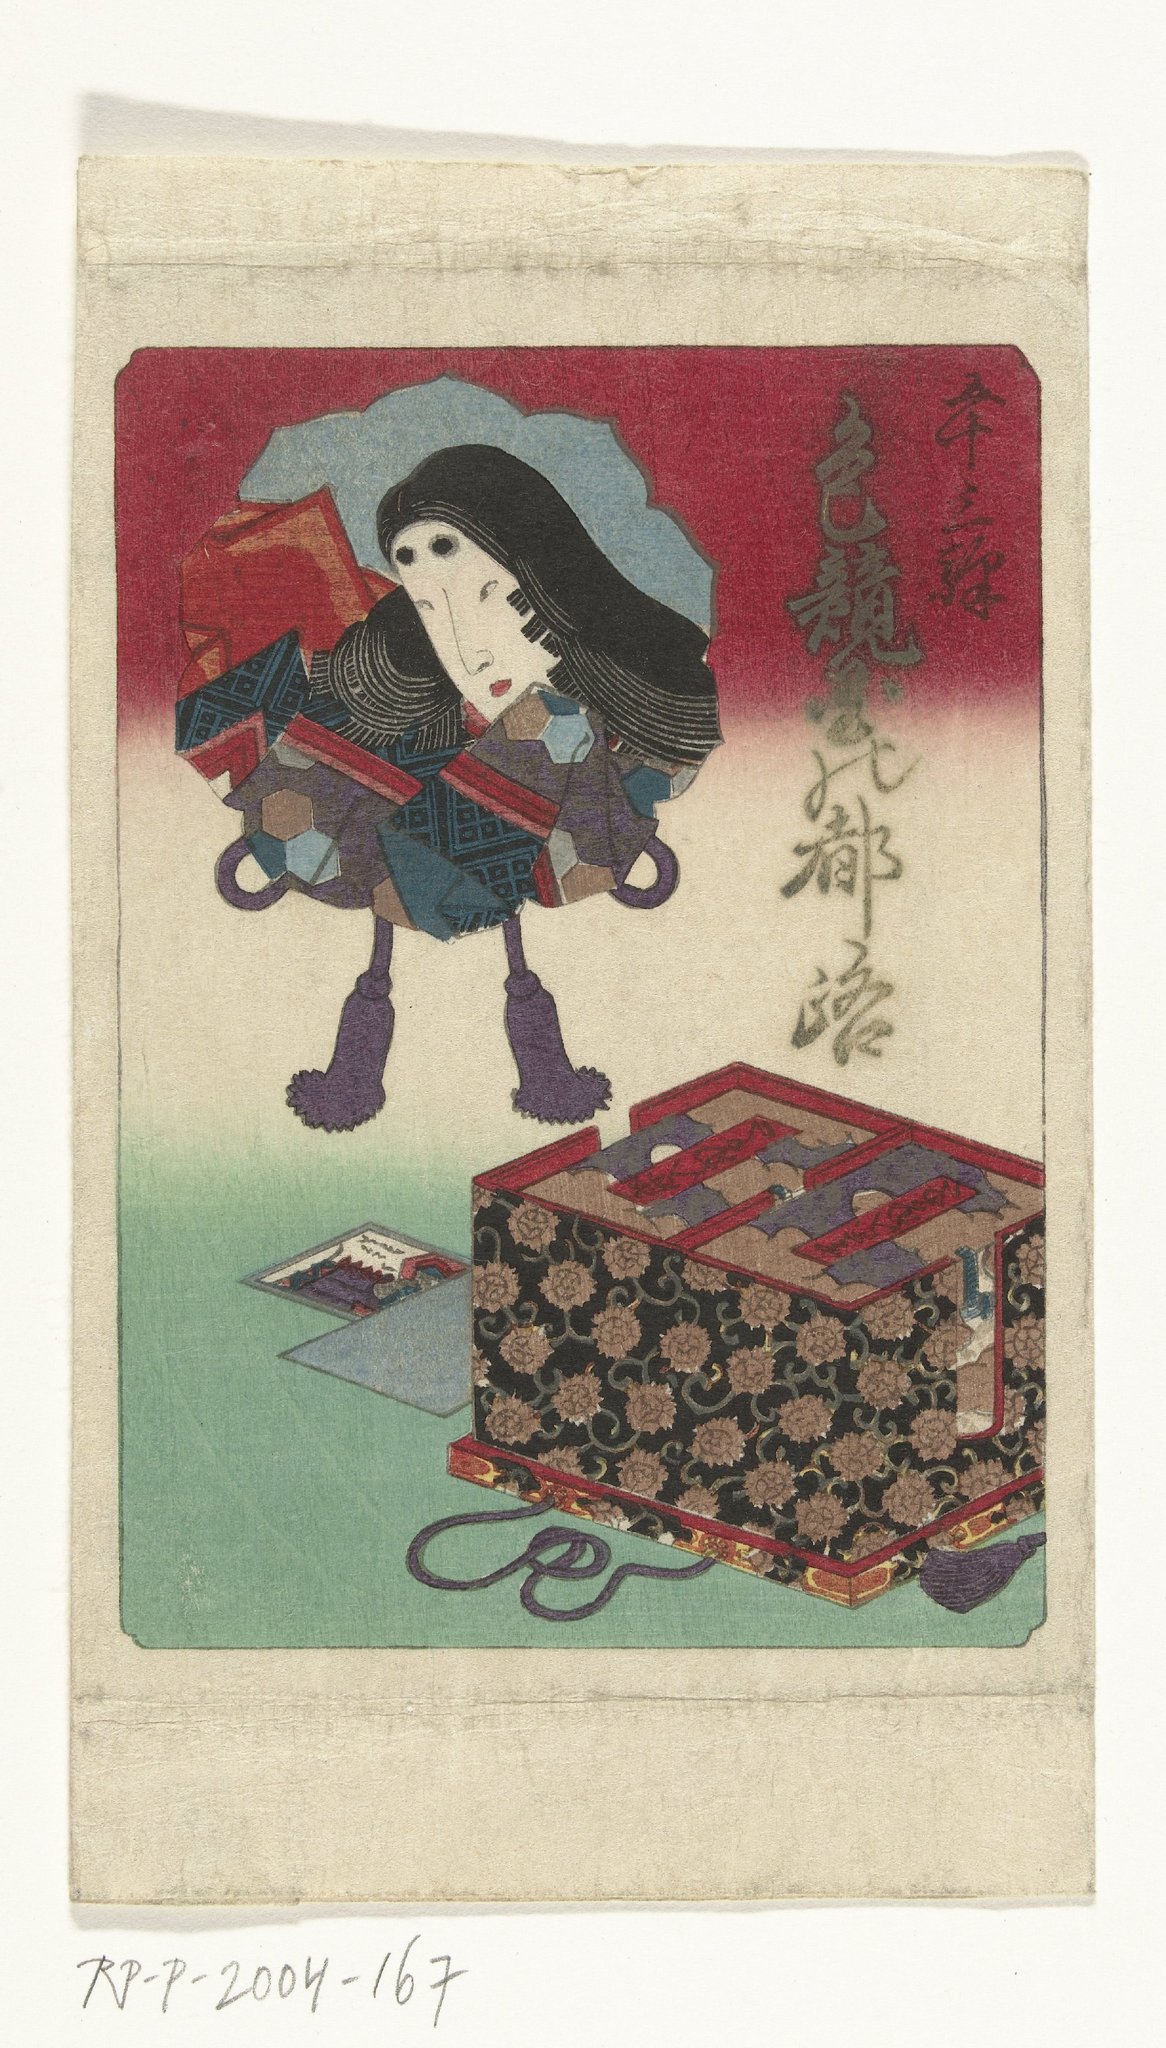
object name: envelope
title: De erotische weg naar de hoofdstad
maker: utagawa kunisada (i)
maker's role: print maker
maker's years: 1786-1865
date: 1835-1845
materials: paper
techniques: woodcut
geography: japan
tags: adult woman, historical persons, chest, coffer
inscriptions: collector's mark: Lugt 2760, collector's mark: Lugt 2228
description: Envelop met afbeelding van doos waarin boeken en linksboven een cartouche met het portret van een vrouw. De envelop diende als omslag voor een serie shunga prentjes met erotische taferelen in pleisterplaatsen op de wegen naar de hoofdstad.